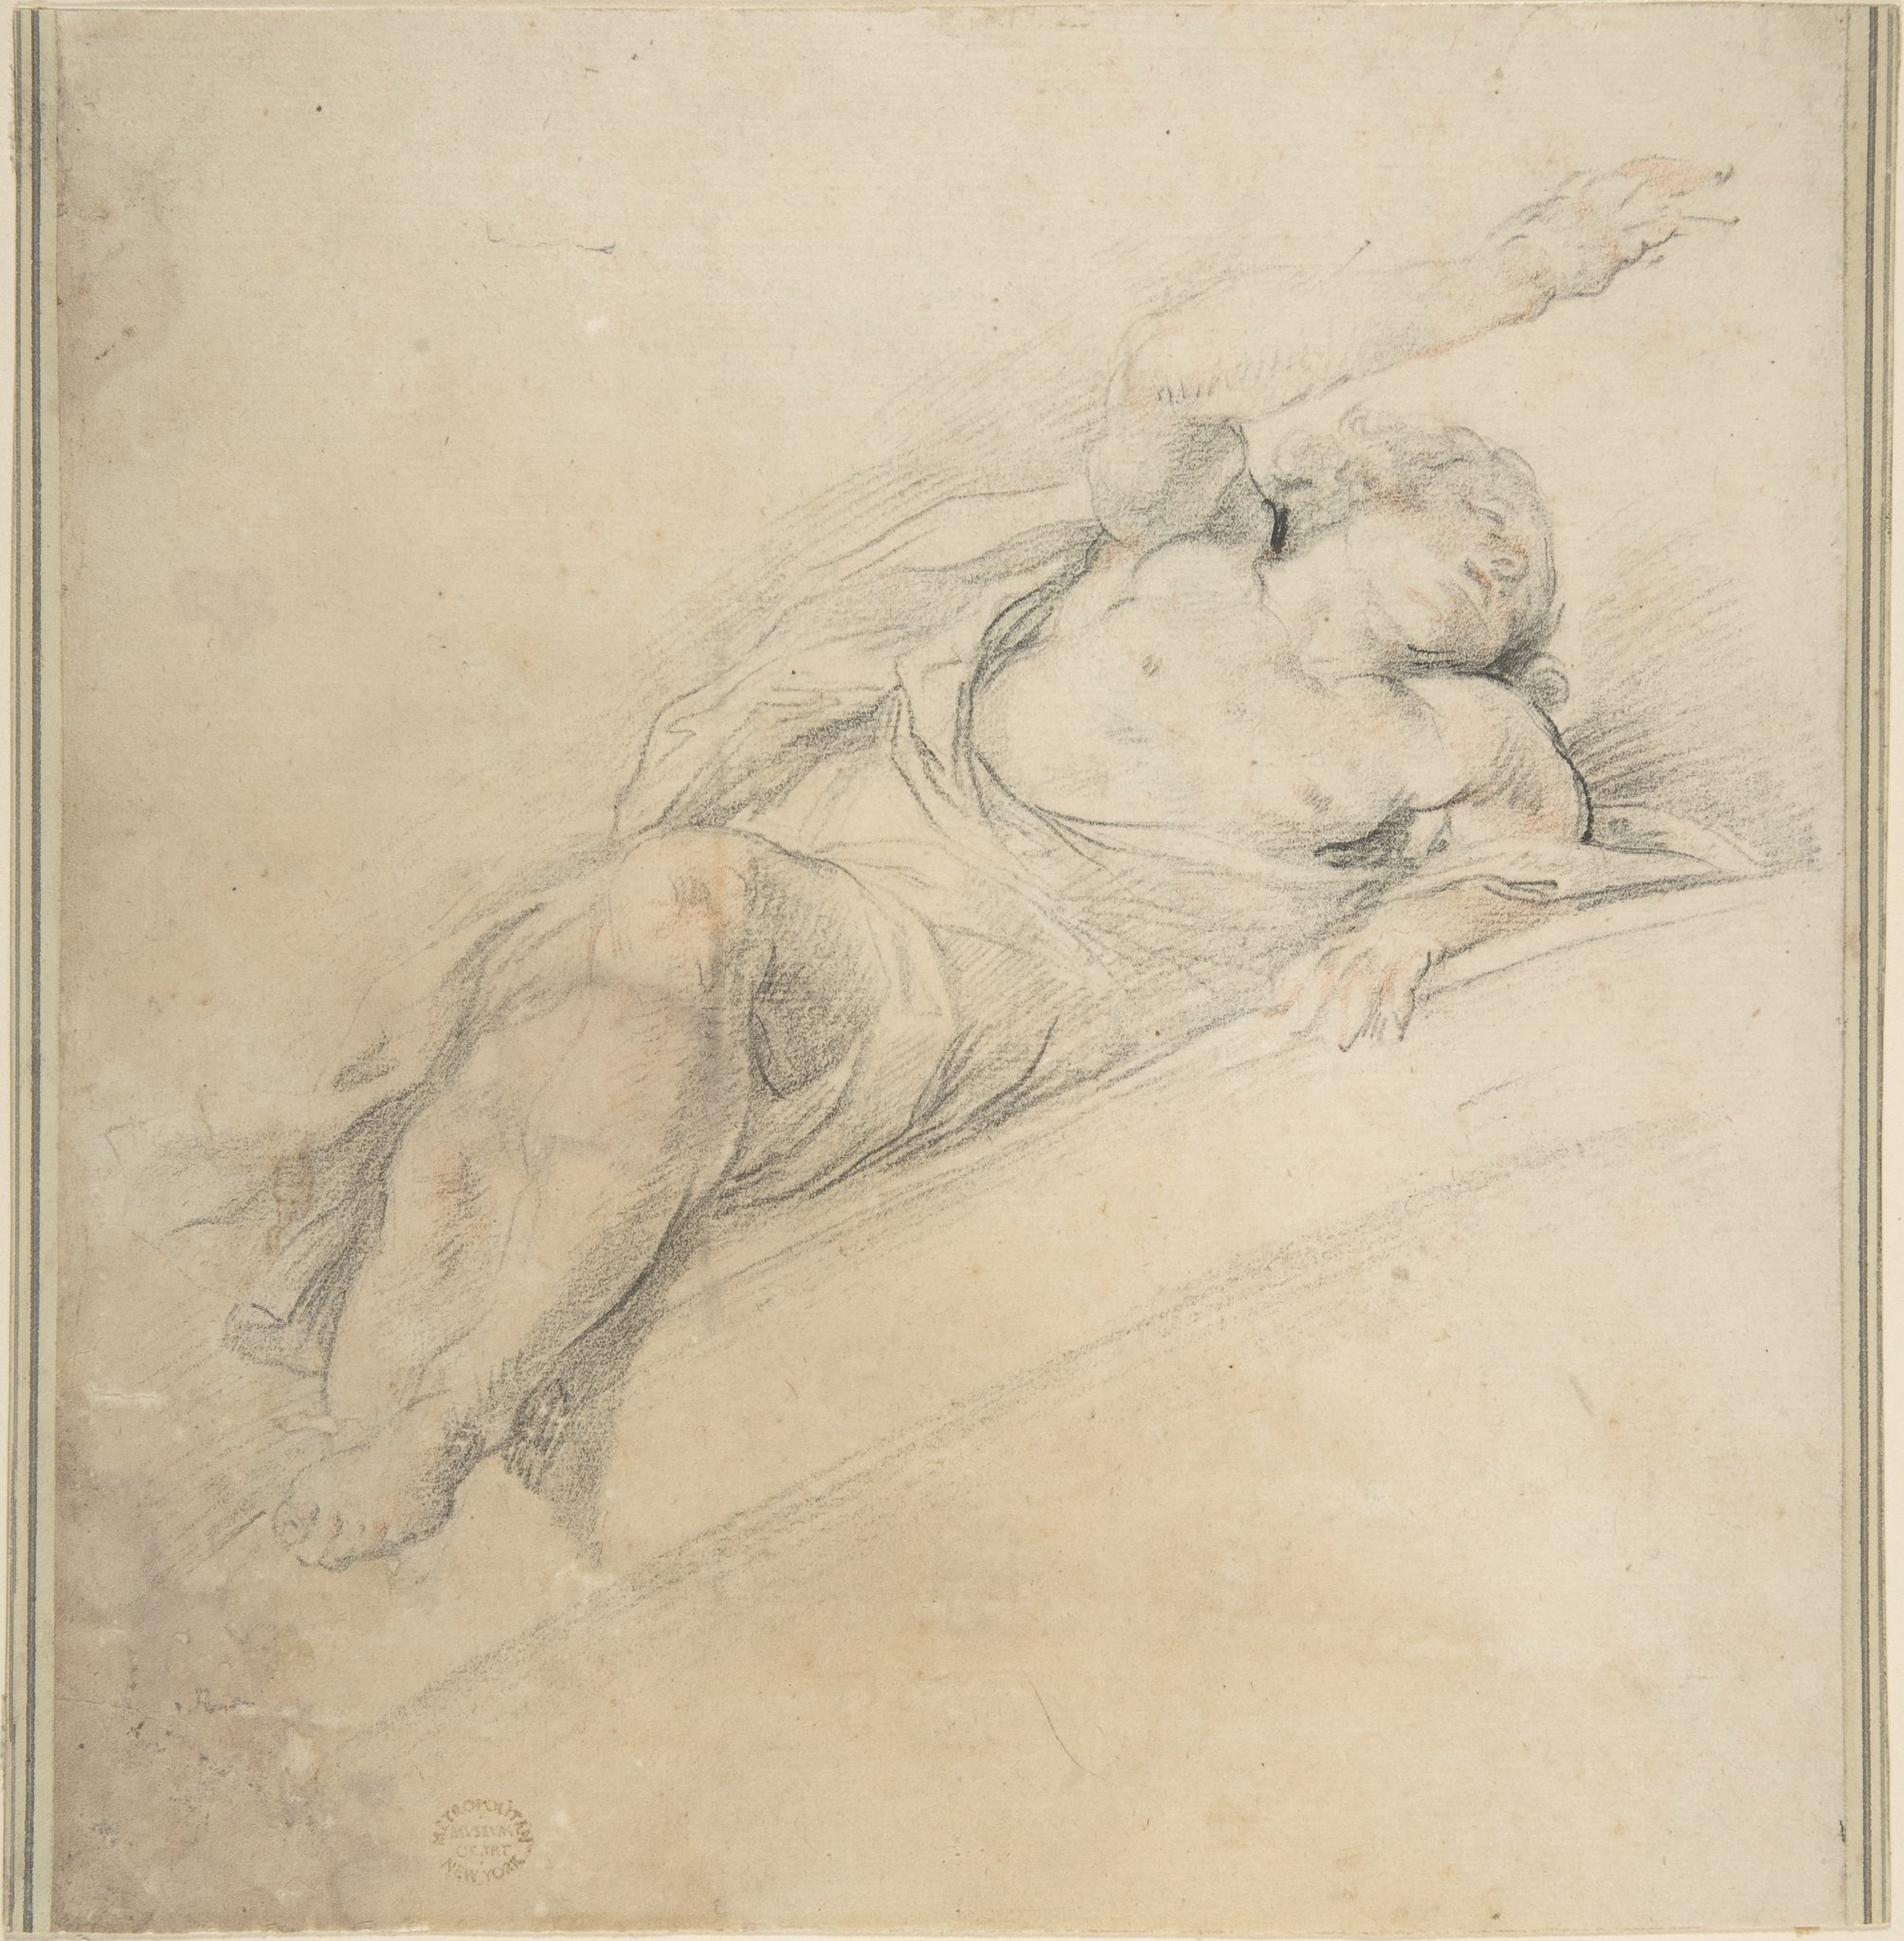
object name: drawing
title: Reclining Figure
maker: anonymous, italian, roman-bolognese, 17th century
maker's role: artist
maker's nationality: italian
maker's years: 1600-1700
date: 1601-1700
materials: chalk, paper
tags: women